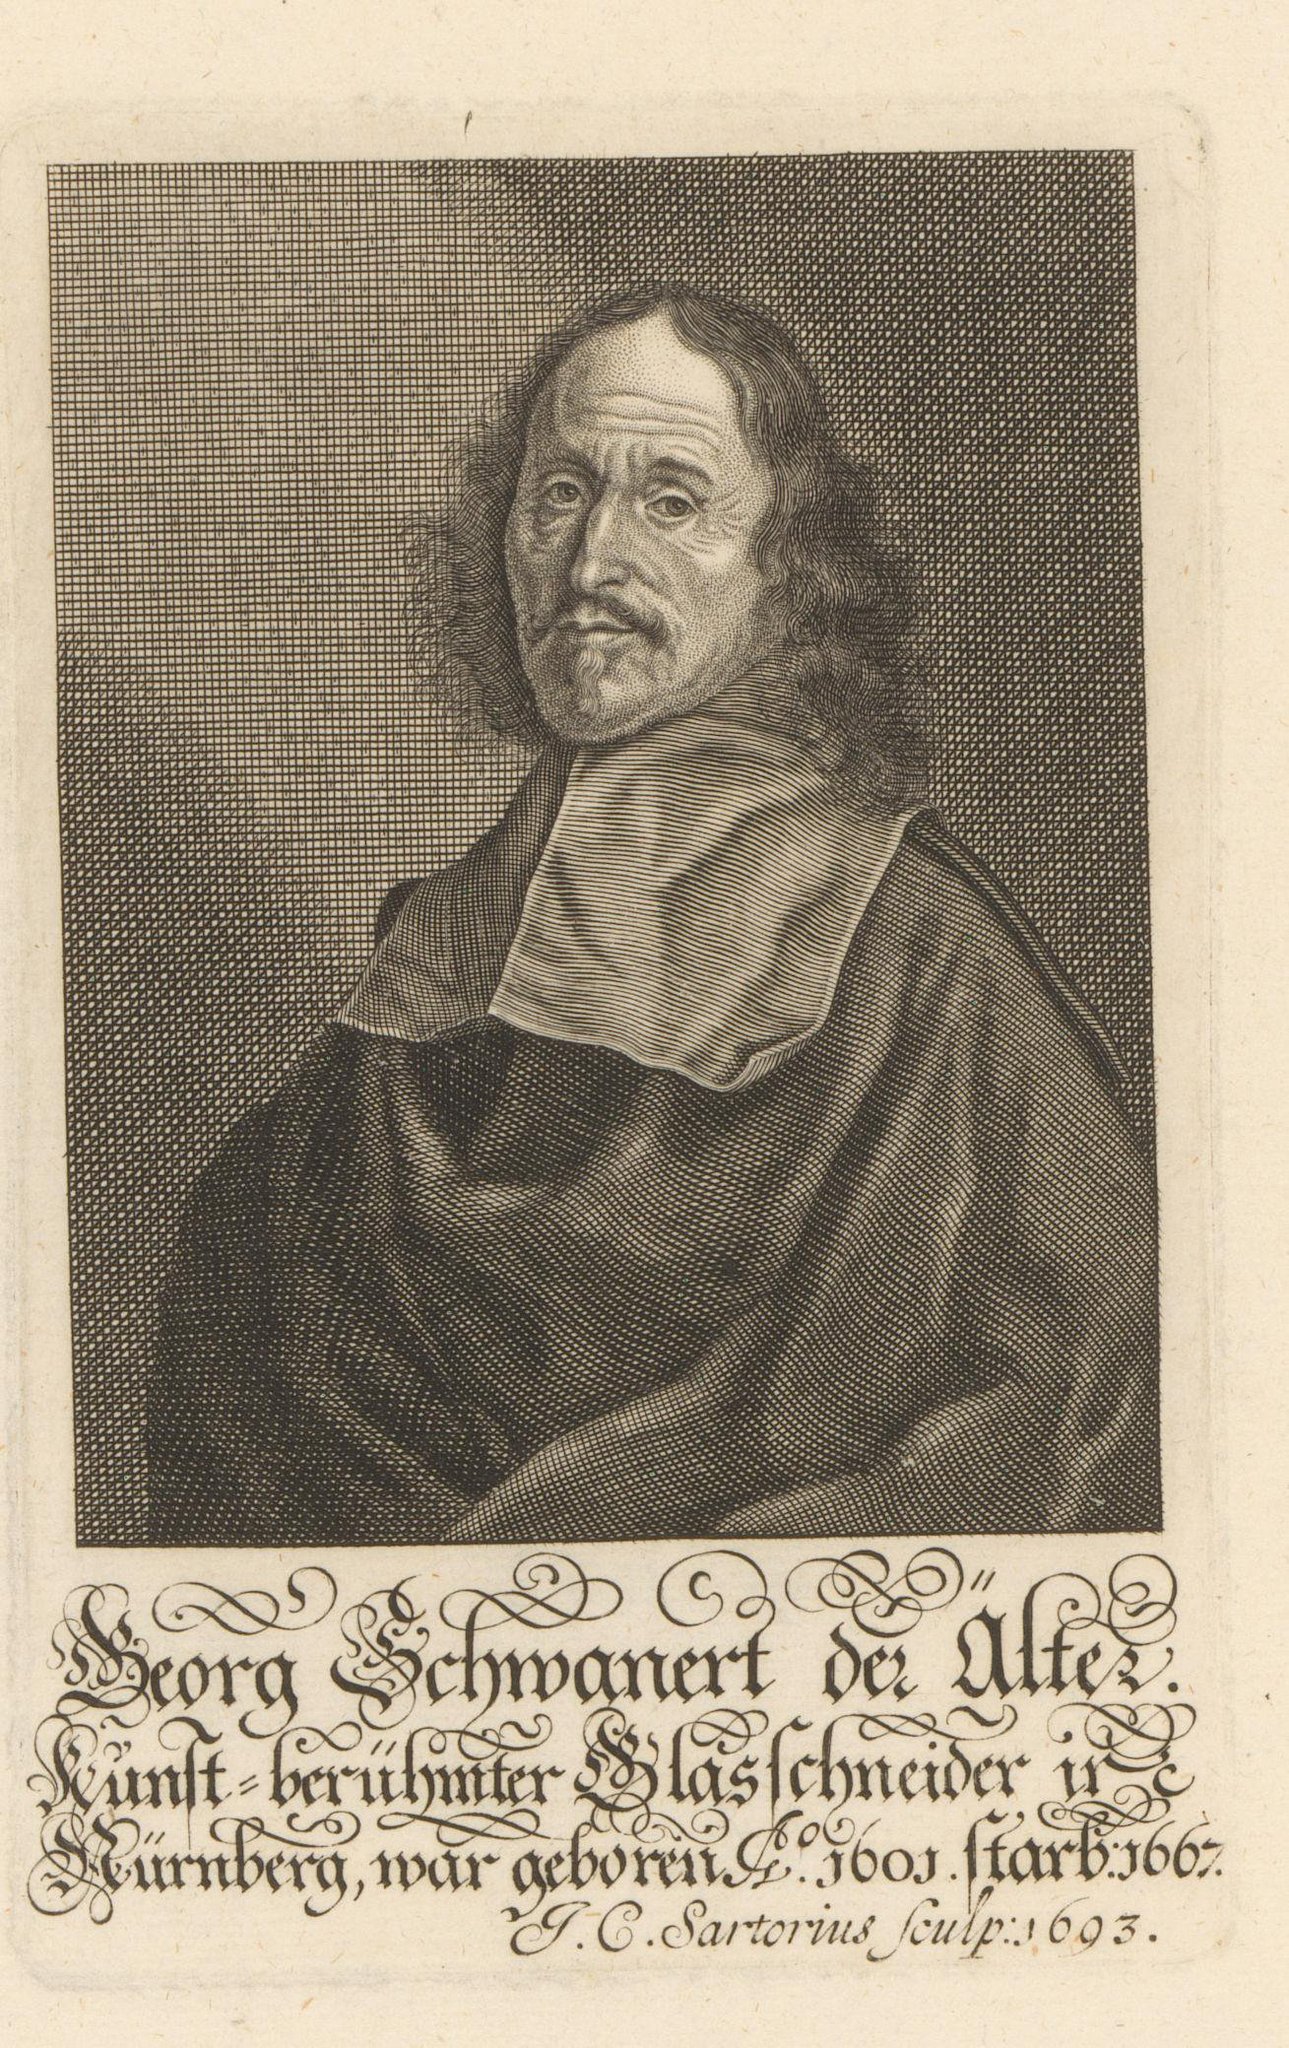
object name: print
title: Portret van Georg Schwanhard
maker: johann christoph sartorius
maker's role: print maker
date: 1680-1739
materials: paper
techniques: engraving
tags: historical persons, portrait, self-portrait of artist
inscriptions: collector's mark: Lugt 2228